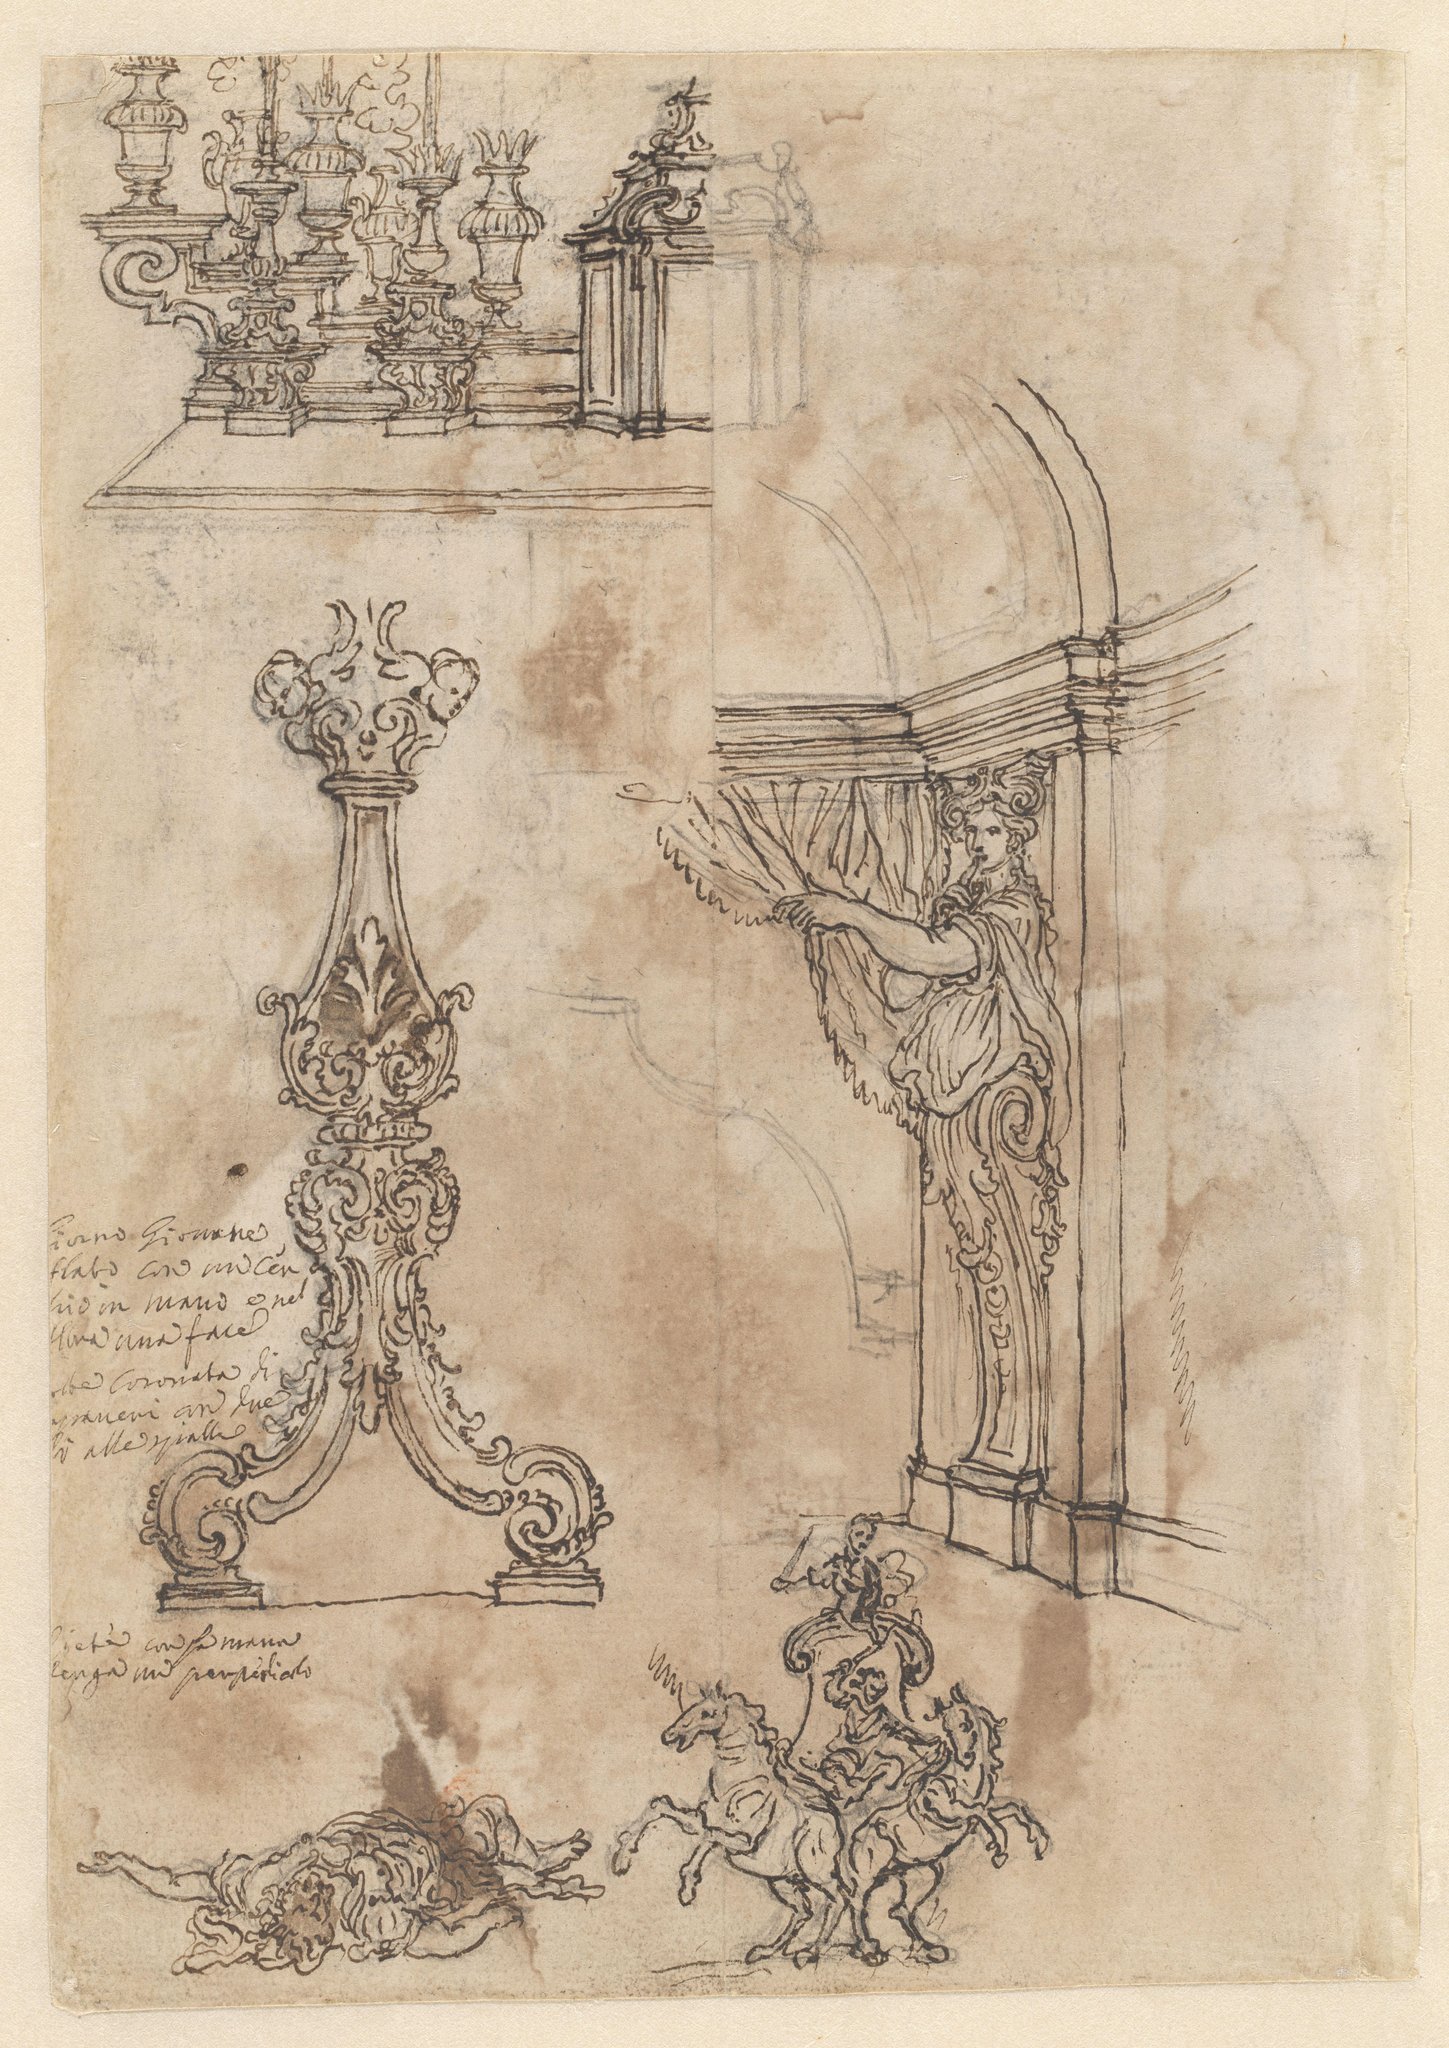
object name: design drawing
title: Linkerdeel van een altaar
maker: giovanni battista foggini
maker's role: draughtsman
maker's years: 1652-1725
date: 1723-1725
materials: chalk, ink, paper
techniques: pen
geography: florence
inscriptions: inscription: ‘Giorno Giovane / alato con un cer / chio in mano e nel / [l'a]ltra una face / [N]otte Coronata di / [p]apaveri con due / [a]li alle spialle / Pietà con la mano / [che] tenga perpandicolo’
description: Altaar met vaasvormige kaarsenhouders, een torchère, de rechterhelft van een bednis, Tulla die een tweespan ment, en een liggende figuur.